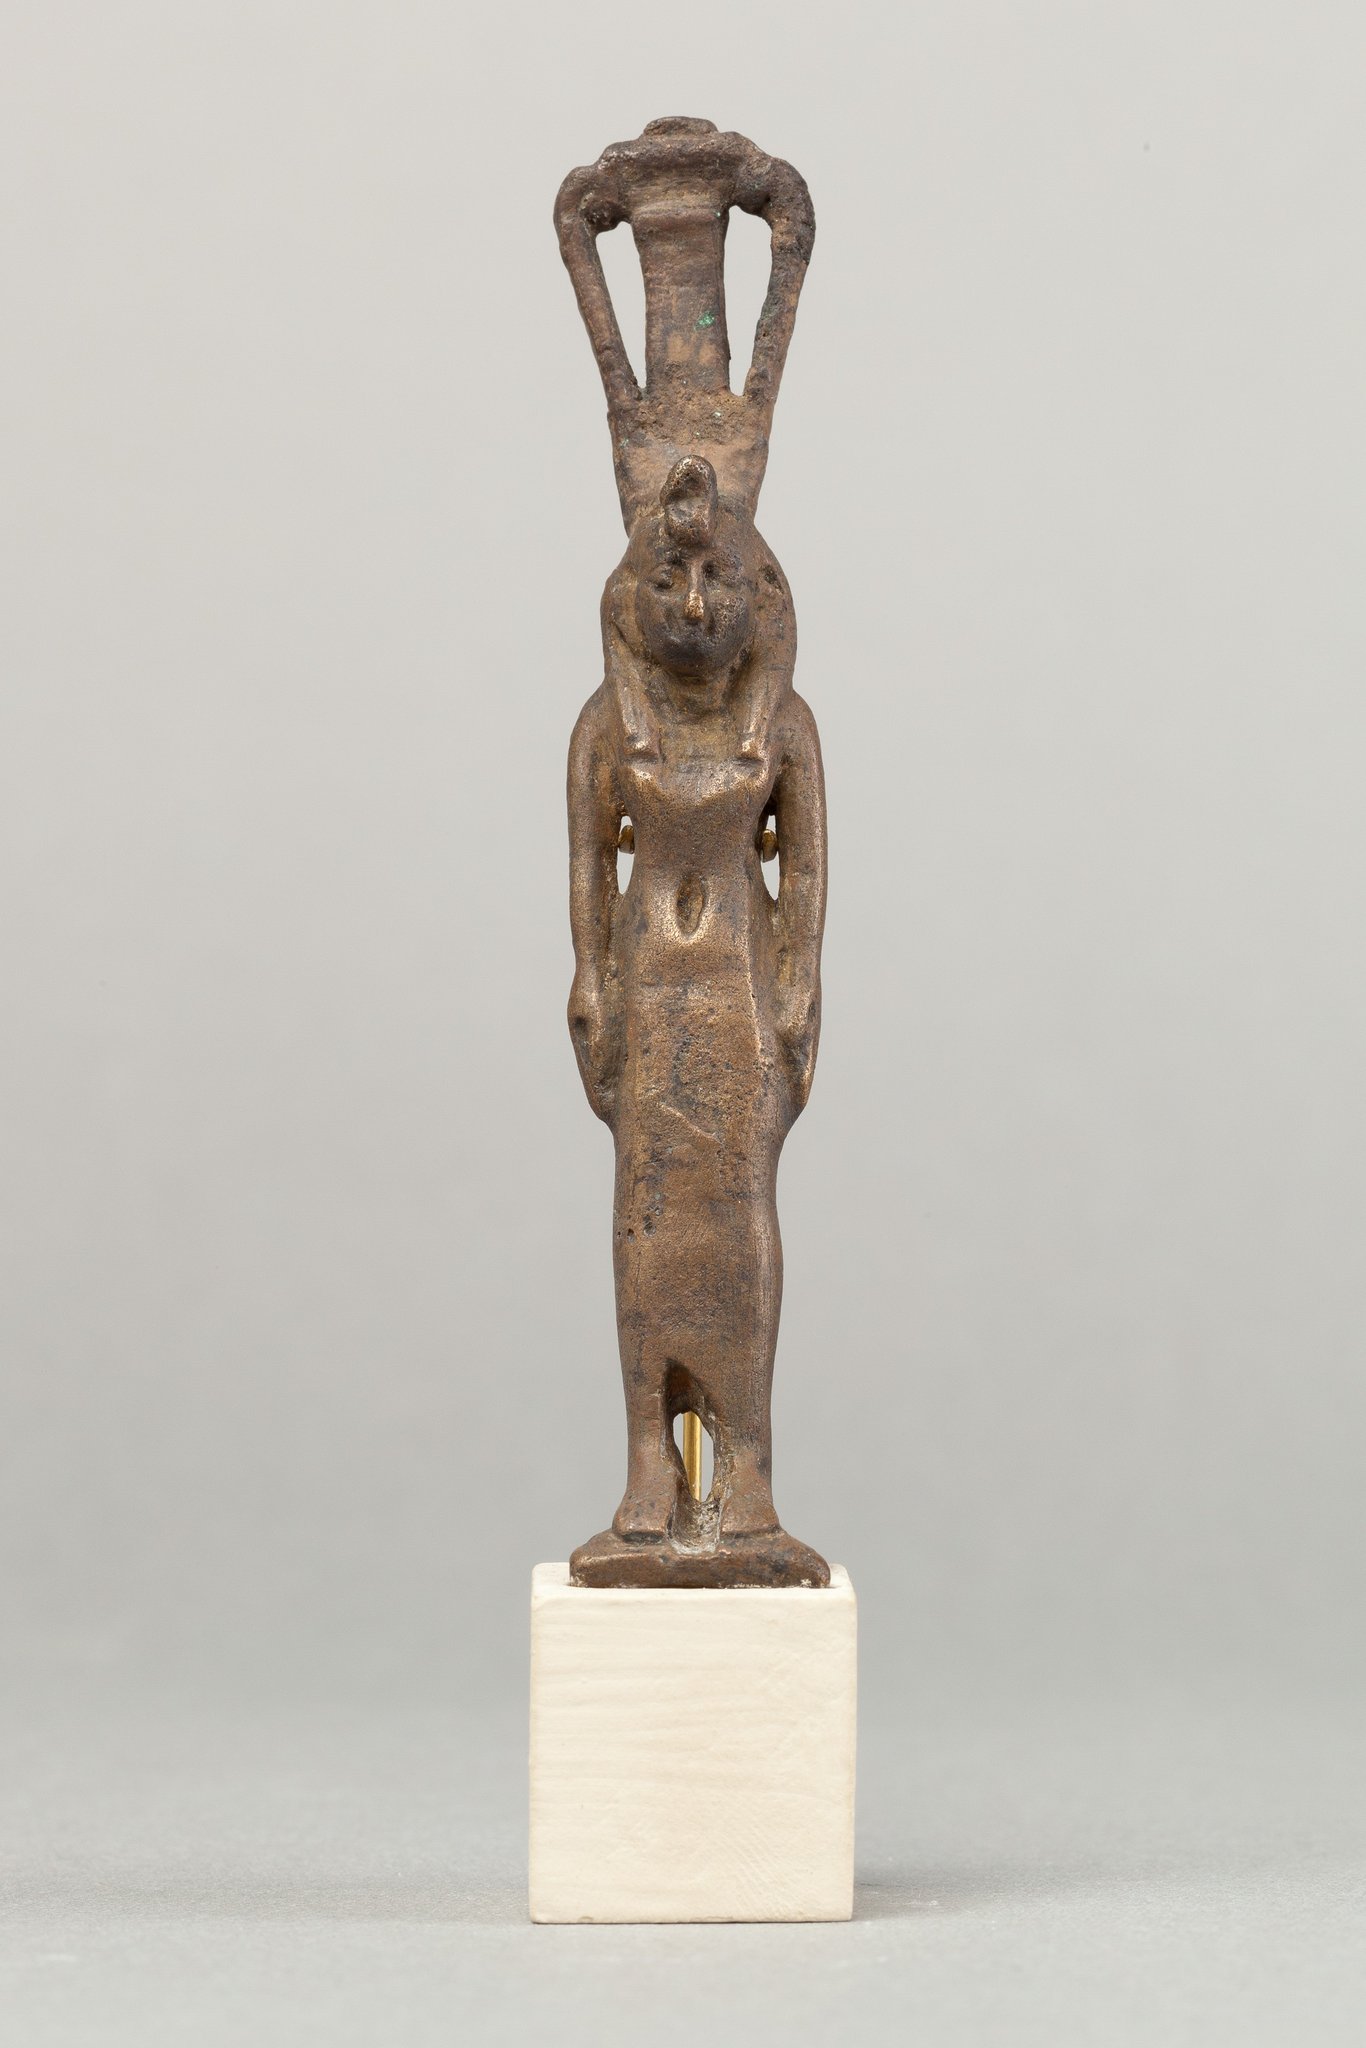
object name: statuette, nehemetaui or nebethetepet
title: Nebethetepet or Nehemetaway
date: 664-630 BCE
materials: metal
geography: egypt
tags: goddess